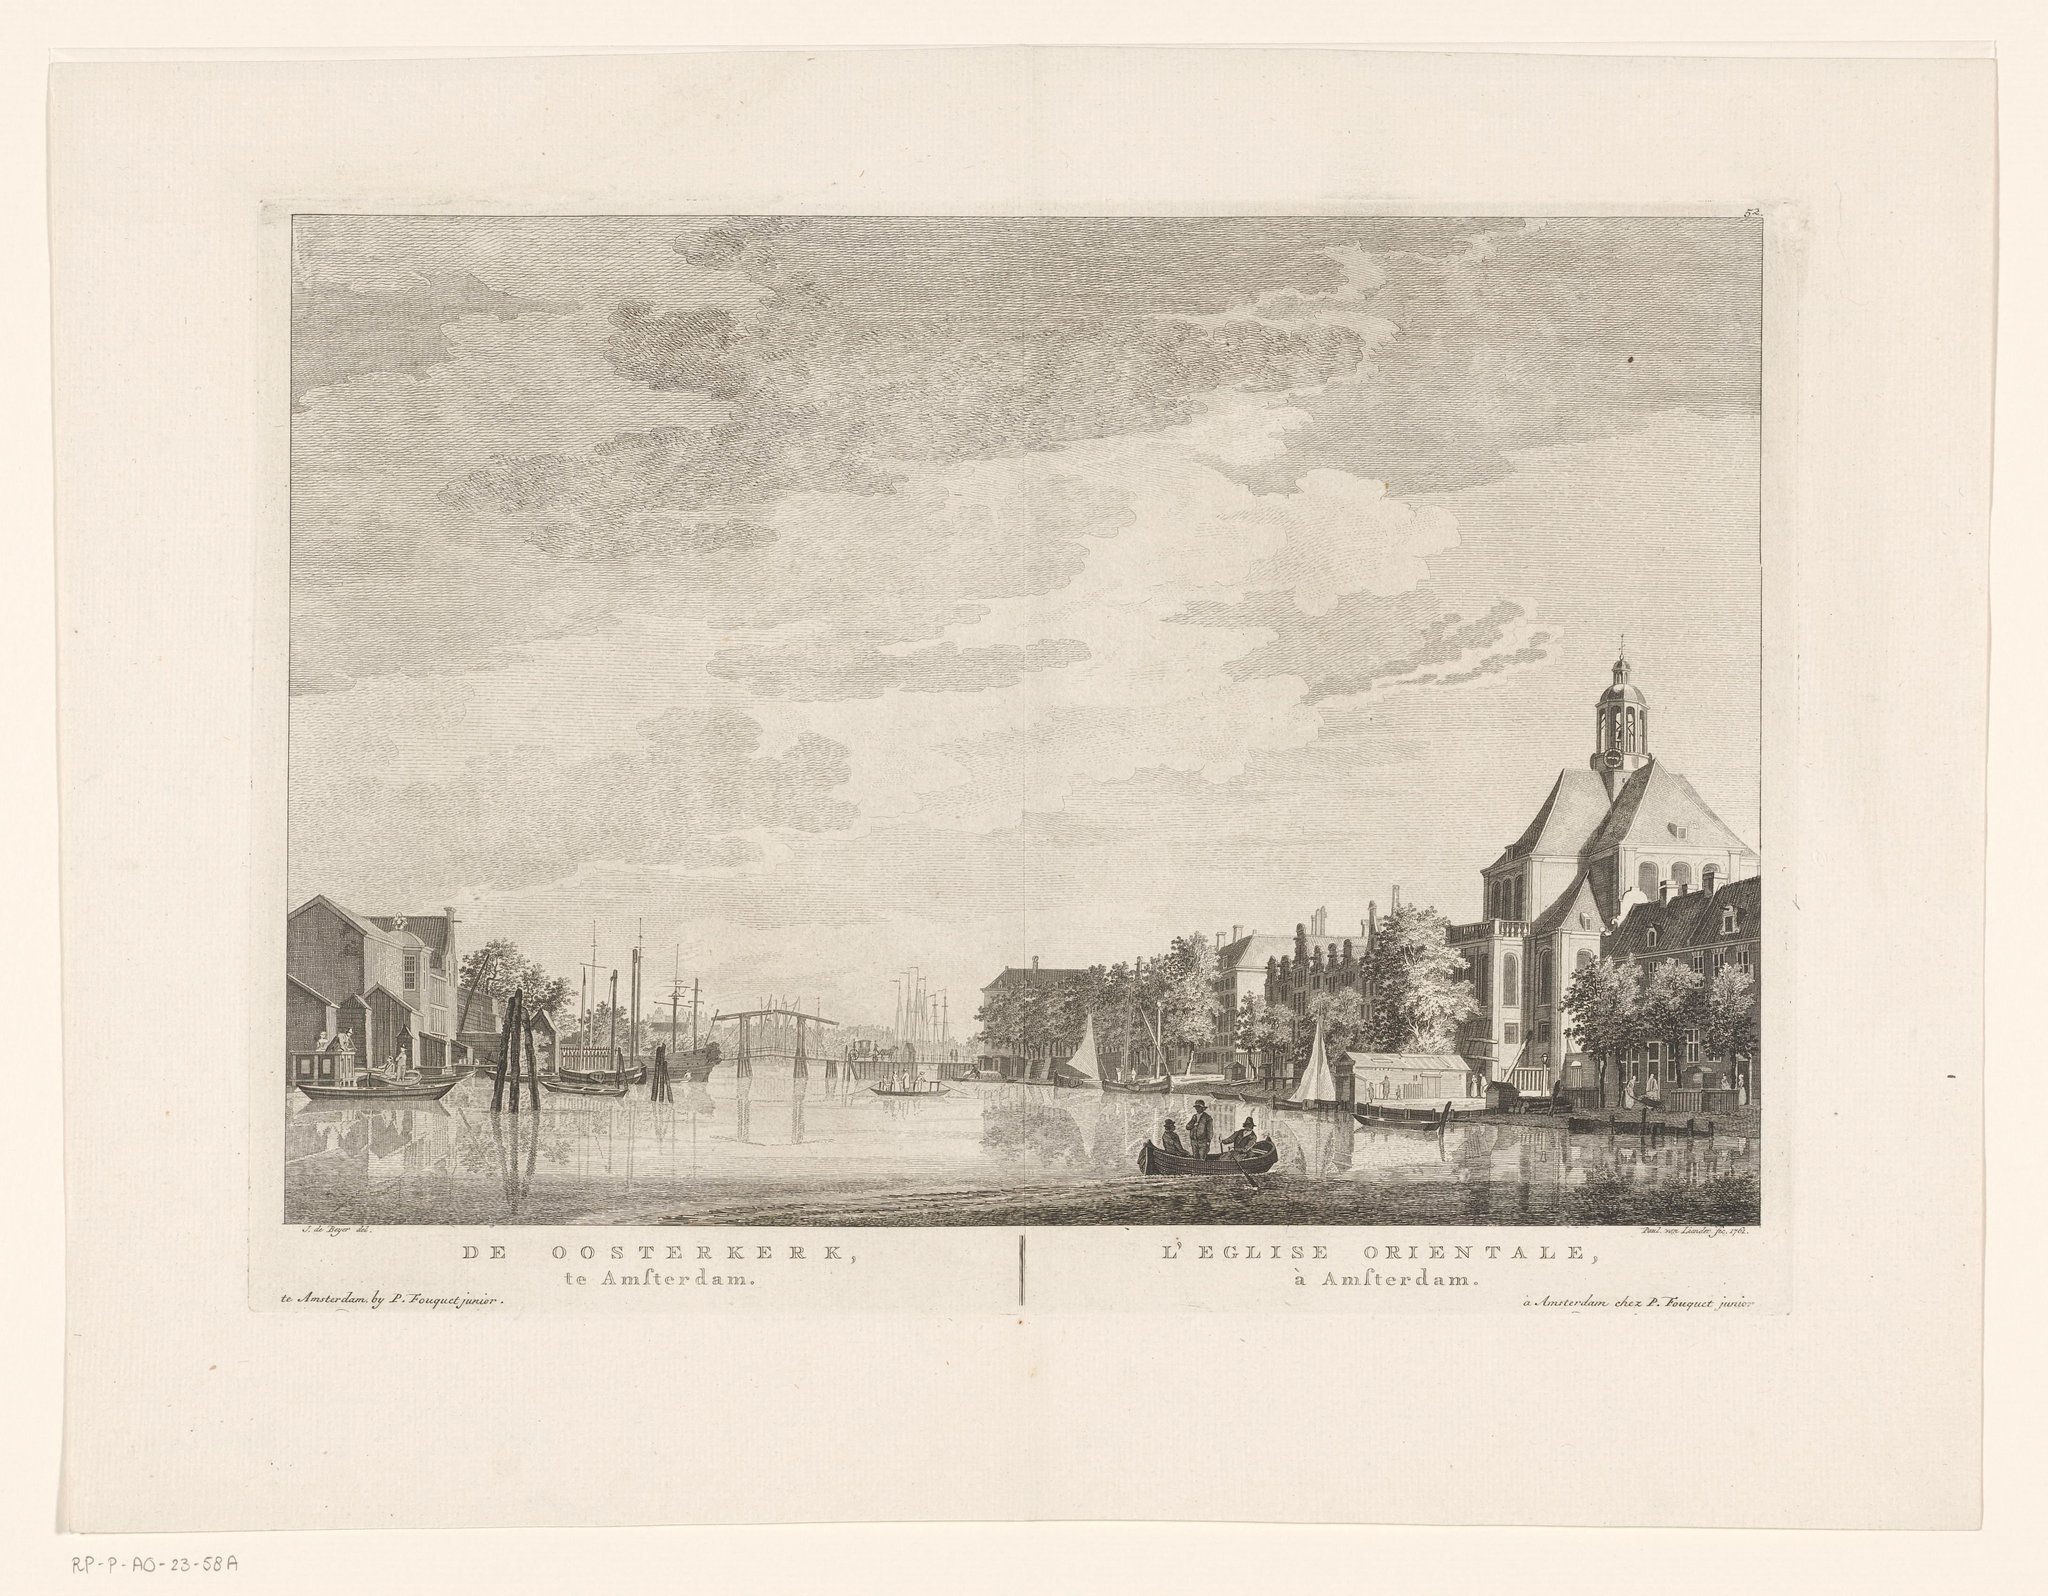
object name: print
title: De Oosterkerk, te Amsterdam / L' Eglise Orientale, à Amsterdam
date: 1761-1783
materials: paper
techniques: engraving, etching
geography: amsterdam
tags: church (exterior), rowing-boat, canoe, etc., canals, waters (in city), bridge in city across river, canal, etc.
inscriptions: collector's mark: Lugt 2228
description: Deze prent is ook gebruikt in de zogenaamde Atlas van Fouquet.* Pierre Fouquet gaf vanaf 1760 stadsgezichten van Amsterdam - naar tekeningen van verschillende kunstenaars, gemaakt door verschillende prentmakers - uit. Deze prenten werden aanvankelijk los of in series verkocht. Zoals toen gebruikelijk kon de koper de prenten zelf laten inbinden. Hiertoe gaf Fouquet tussen 1778 en 1783 een titelblad, plattegrond en inhoudsopgave van de tot dusver 100 uitgegeven prenten uit (1). Gezien de inhoud afhankelijk was van wat de koper had verzameld verschilt de inhoud van de verschillende bewaarde Fouquetatlassen onder deze titel sterk. Ook zijn er exemplaren bekend waar tevens andere prenten aan zijn toegevoegd. Omdat er behoefte bleek aan uitleg bij de platen werd in 1783 een nieuwe versie van de atlas uitgegeven, aangevuld met tekst en twee prenten. De aangegeven volgorde veranderde maar de platen van de al eerder uitgegeven prenten bleven ongewijzigd. Deze uitgave werd in opdracht van Fouquet gedrukt bij Daniël Jean Changuion en Petrus den Hengst (2). Een tiental platen werd bijgewerkt en verscheen, met nieuw impressum, in het vervolg van Wagenaars geschiedenis van Amsterdam, uitgeven door Petrus Conradi en Folkert van der Plaats (3). Een aantal jaar na het overlijden van Fouquet kwam Evert Maaskamp met een nieuwe uitgave van de atlas, met verbeterde tekst en toevoeging van twee prenten. Op alle platen verwijderde hij het oude en liet hij zijn eigen impressum zetten (4). De huidige staat van de prent komt voor in exemplaren van de onder (1) en (2) genoemde werken. * Onder de Atlas van Fouquet of Fouquetatlas verstaan we de hieronder vermelde publicaties (1), (2) en (4). (1). Afbeeldingen van de wyd-vermaarde koopstad Amsterdam benevens des zelvs voornaamste gebouwen en gezigten alle naar het leeven getekend / Receuil des edifices les plus considerables et des plus belles vues, de la fameuse ville d'Amsterdam, dessinées d'après nature. Amsterdam: Pierre Fouquet, 1778-1783. (2). Nieuwe atlas, van de voornaamste gebouwen en gezigten der stad Amsterdam, met derzelver beknopte beschryvingen. 2 delen. Amsterdam: Daniël Jean Changuion en Petrus den Hengst [in opdracht van Pierre Fouquet], 1783. (3). Stijl, Simon. Amsterdam, in zyne geschiedenissen, voorregten, koophandel, gebouwen, kerkenstaat, schoolen, schutterye, gilden en regeeringe, beschreeven. Om te dienen ten vervolge op het werk van Jan Wagenaar (…). 10 delen. Amsterdam en Harlingen: Petrus Conradi en Folkert van der Plaats, 1788-1801. (4). Nieuwe atlas, van de voornaamste gebouwen en gezigten der stad Amsterdam. Met derzelver beknopte beschryvingen. Amsterdam: Evert Maaskamp, 1805. * Het aantal vermelde staten is gebaseerd op het aantal gevonden staten. Mogelijk zijn er meer staten van deze prent. Voor eerste bekende staat zie RP-P-AO-23-58. Voor tweede bekende staat zie RP-P-OB-46.351. Voor vijfde bekende staat zie RP-P-1905-512.